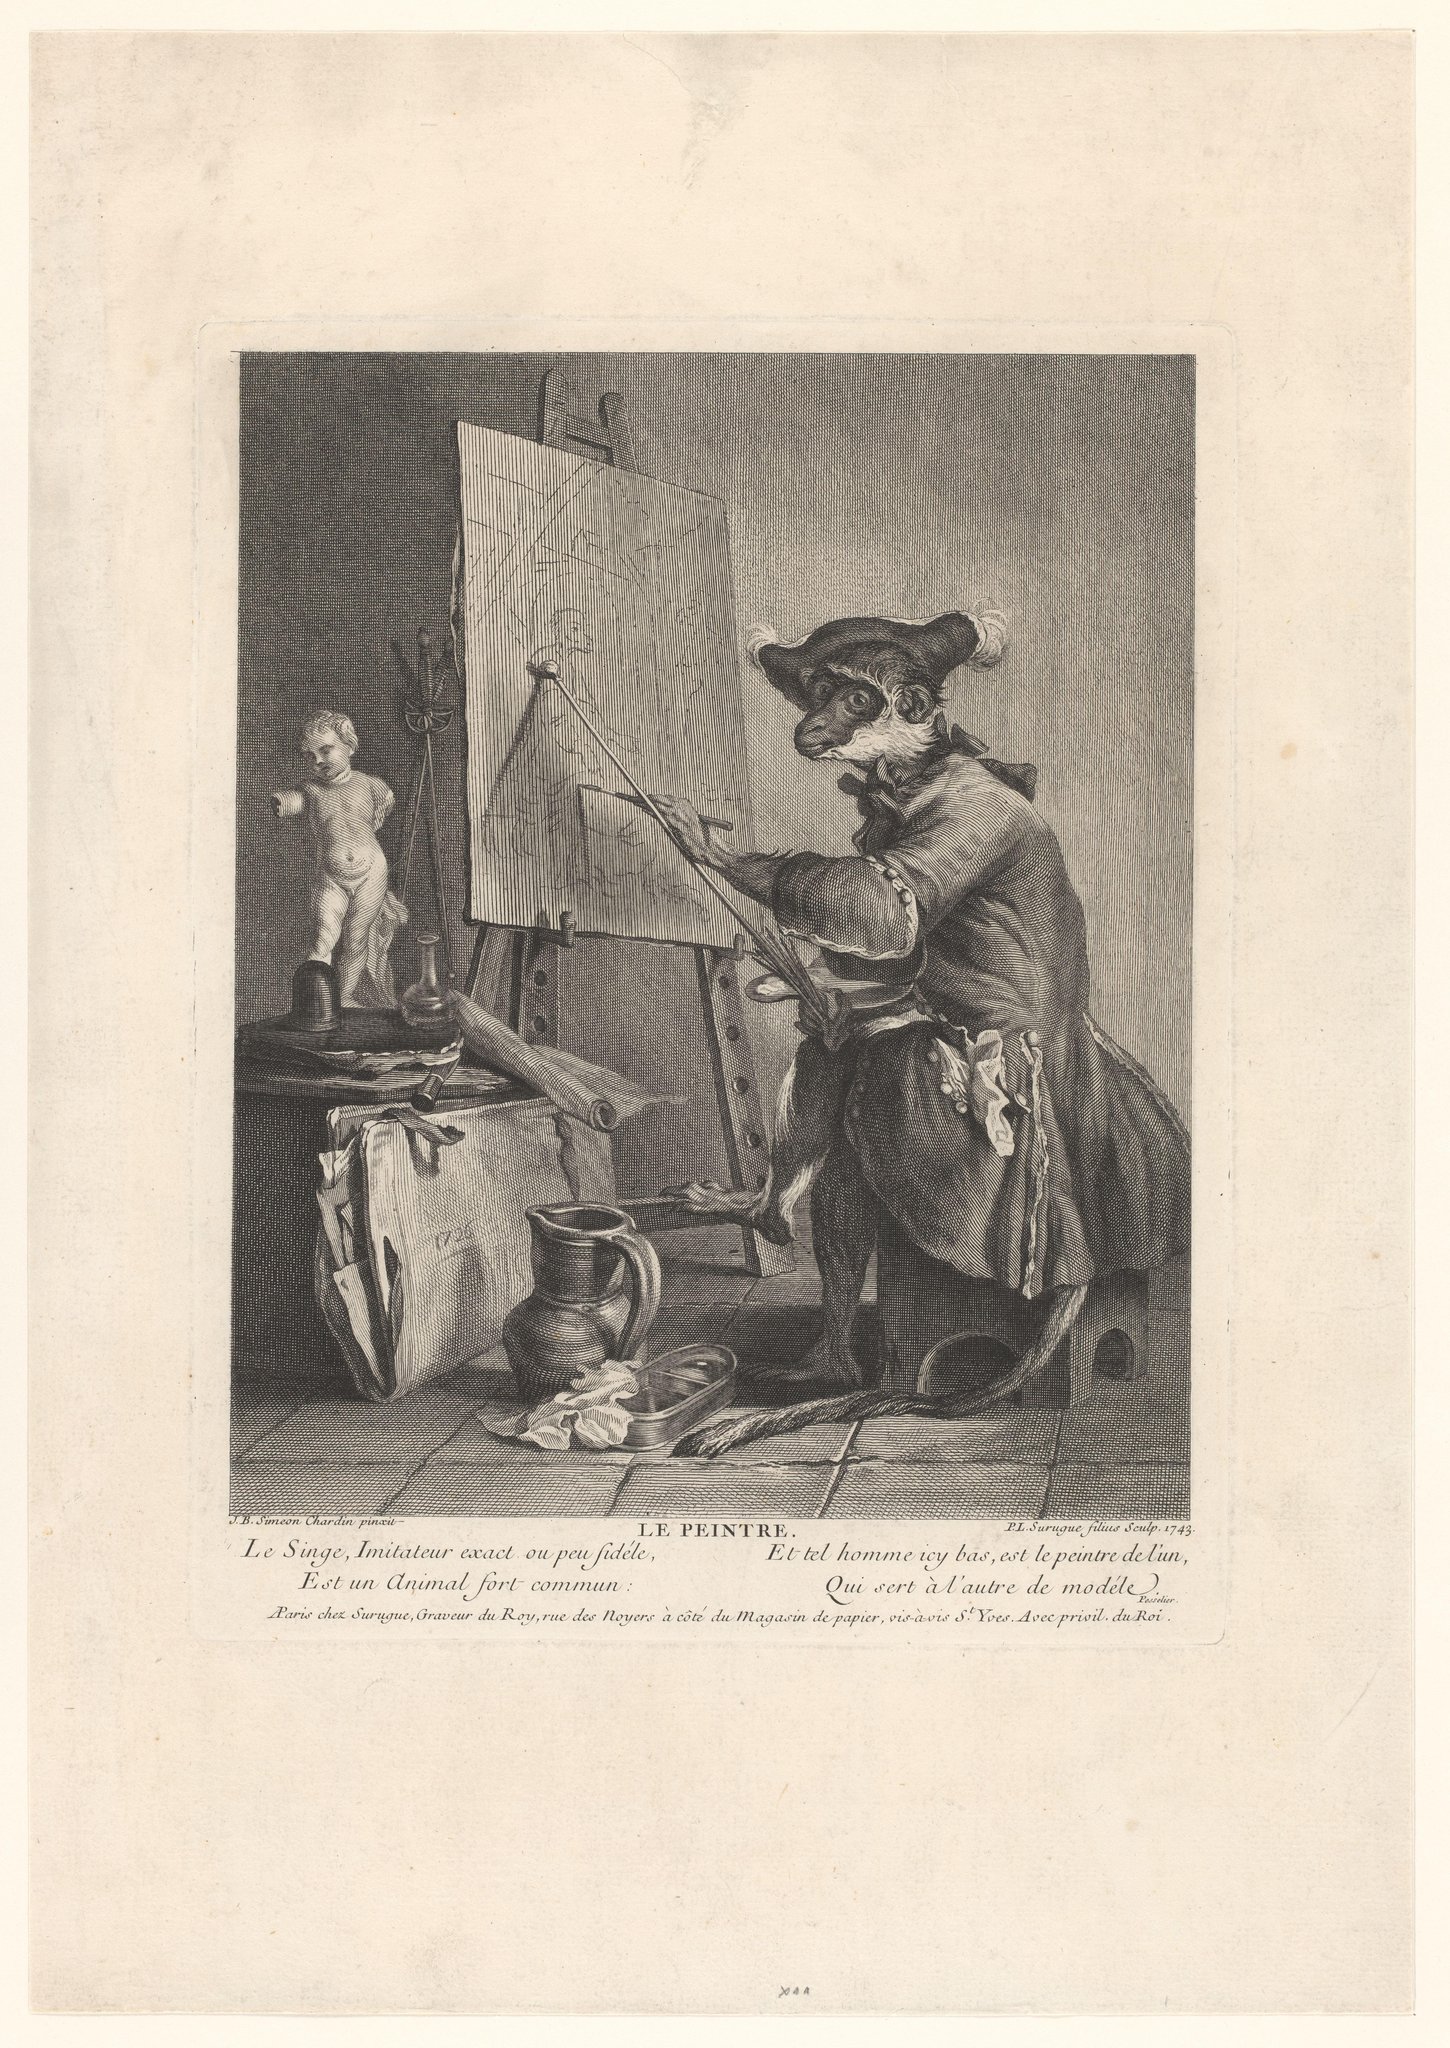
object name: print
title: Le Peintre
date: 1743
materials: paper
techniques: engraving, etching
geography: paris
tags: monkeys, apes, animals acting as human beings, painter at work, in his studio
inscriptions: collector's mark: Lugt 2760, collector's mark: Lugt 2228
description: Een aap voorgesteld als schilder, gekleed in modieus kostuum in een atelier, gezeten achter een schildersezel met in zijn poten een schildersezel, penseel en palet.